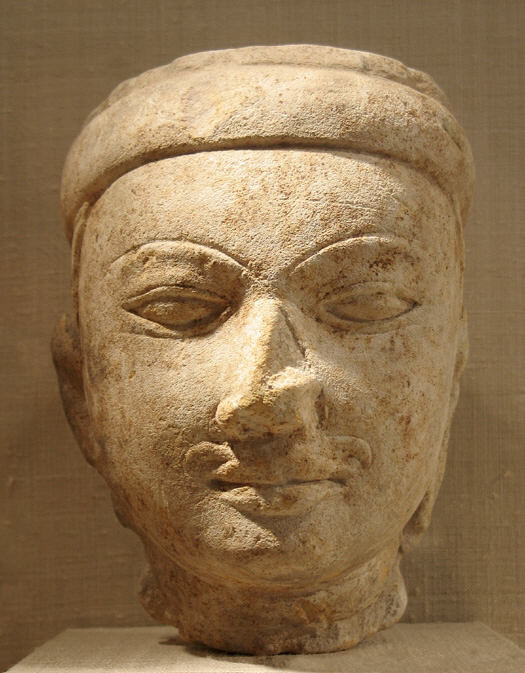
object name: head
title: Head of a Male Deity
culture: burmese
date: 1001-1100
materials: stone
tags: faces,heads,men